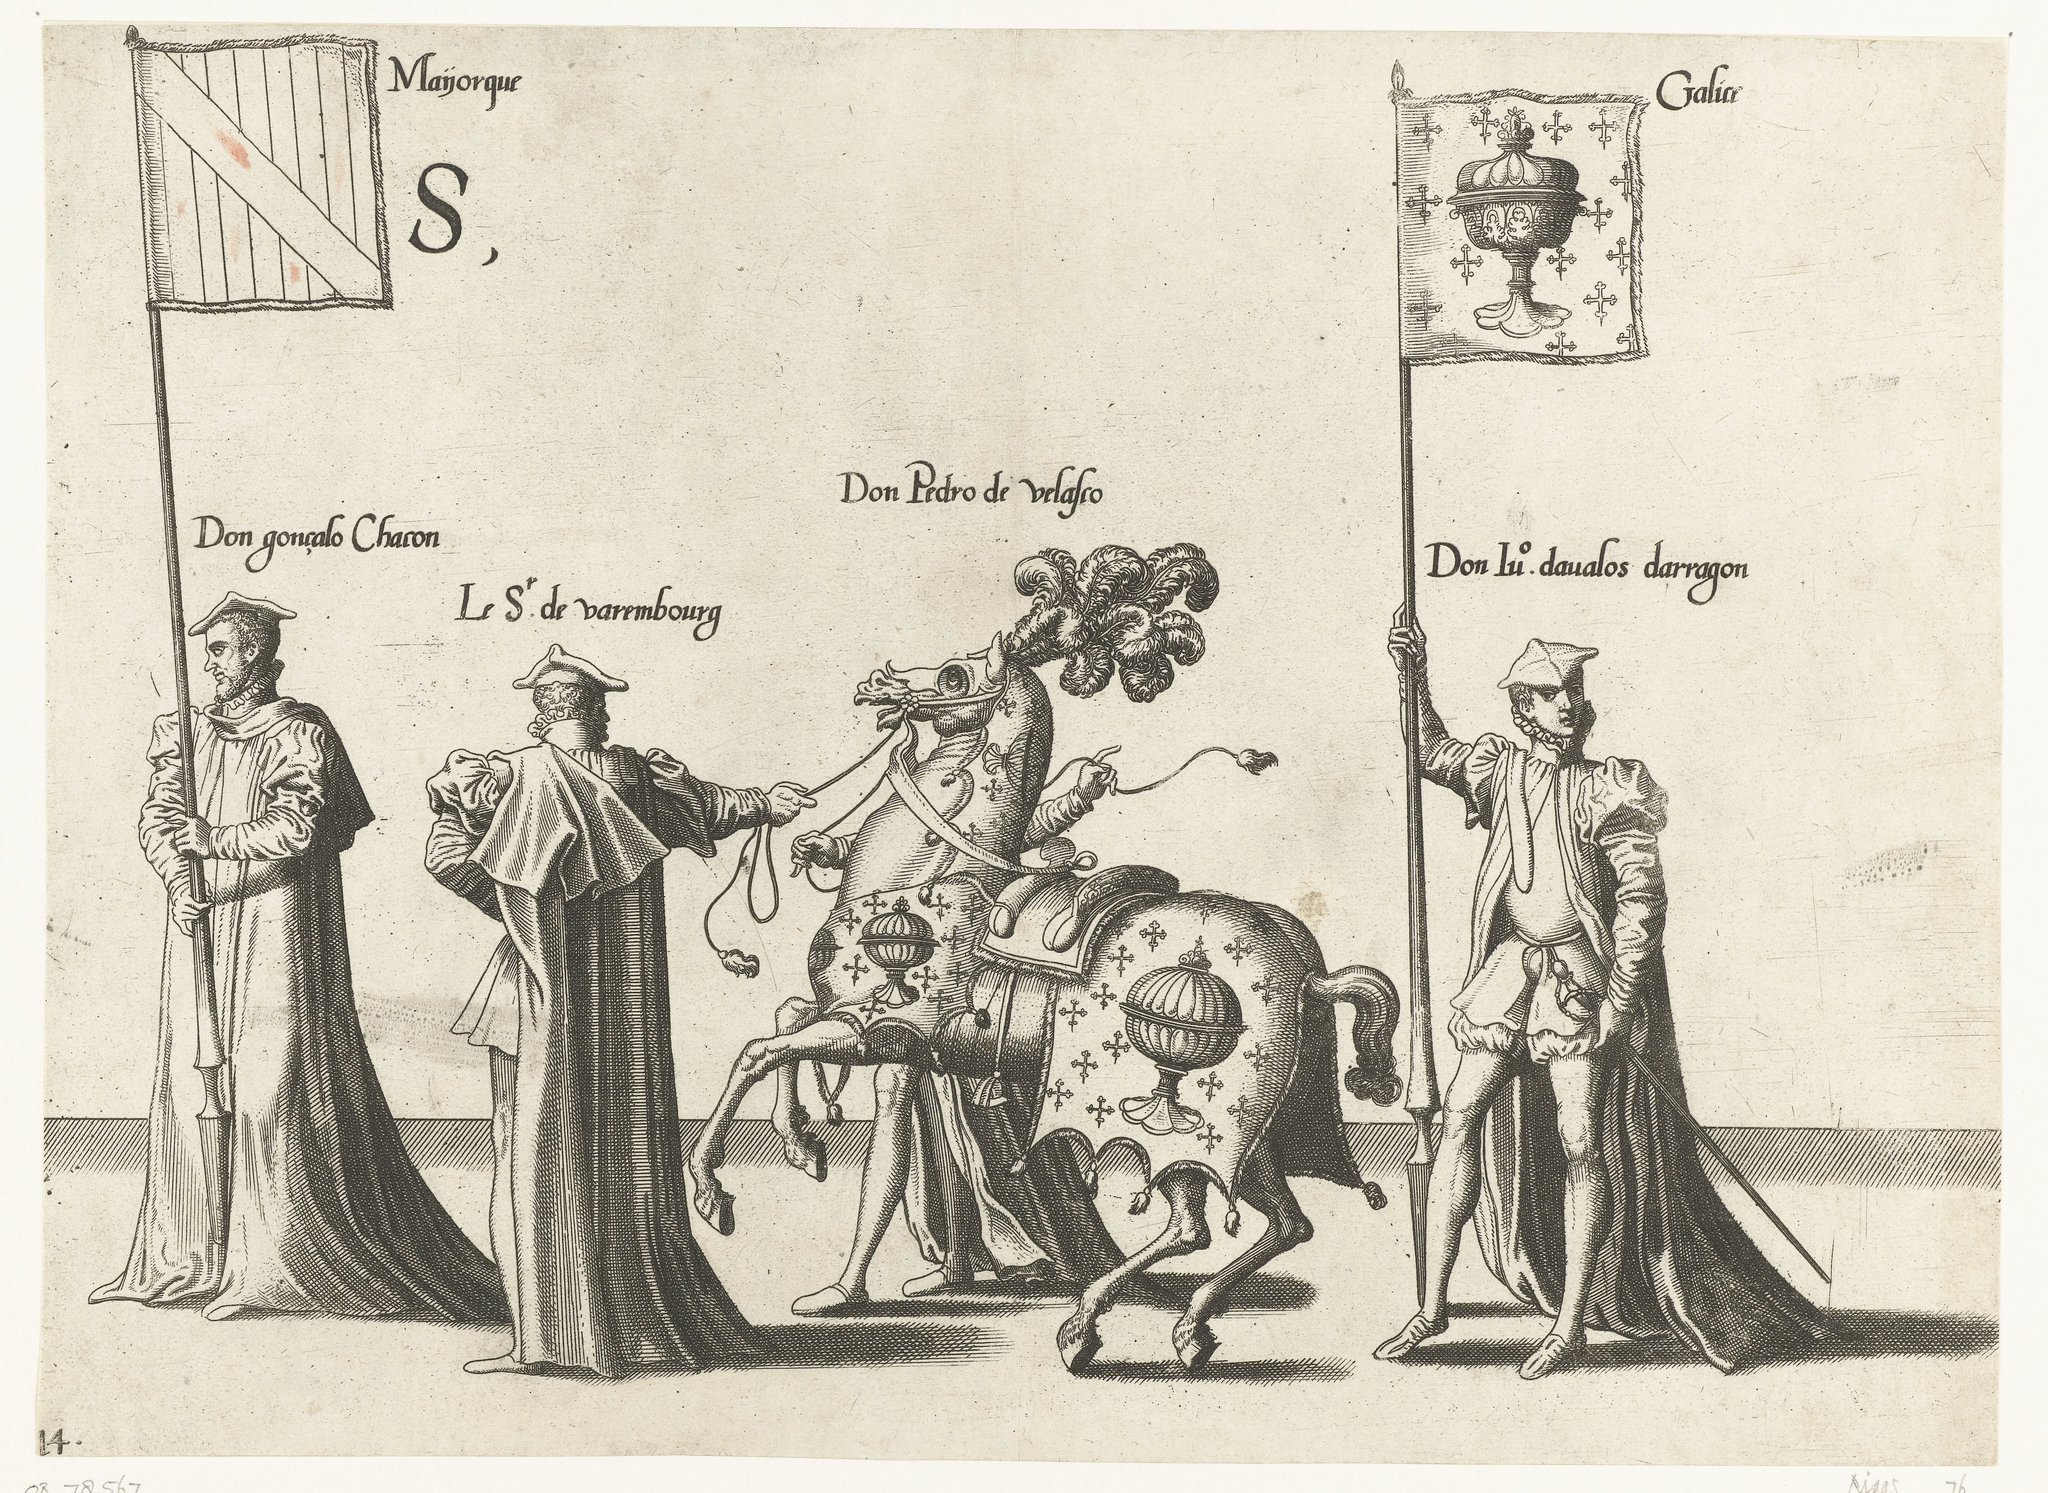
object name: print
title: Begrafenisoptocht van keizer Karel V, 1558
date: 1559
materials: paper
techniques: engraving, etching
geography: southern netherlands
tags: ghent, charles v (holy roman emperor and king of spain), cortege, funeral procession, brussels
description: Vier deelnemers aan de optocht, paarden en de vaandels met de wapens van Mallorca en Galicië. Onderdeel van de prentreeks van de Begrafenisoptocht van keizer Karel V op 29 december 1558 te Brussel.